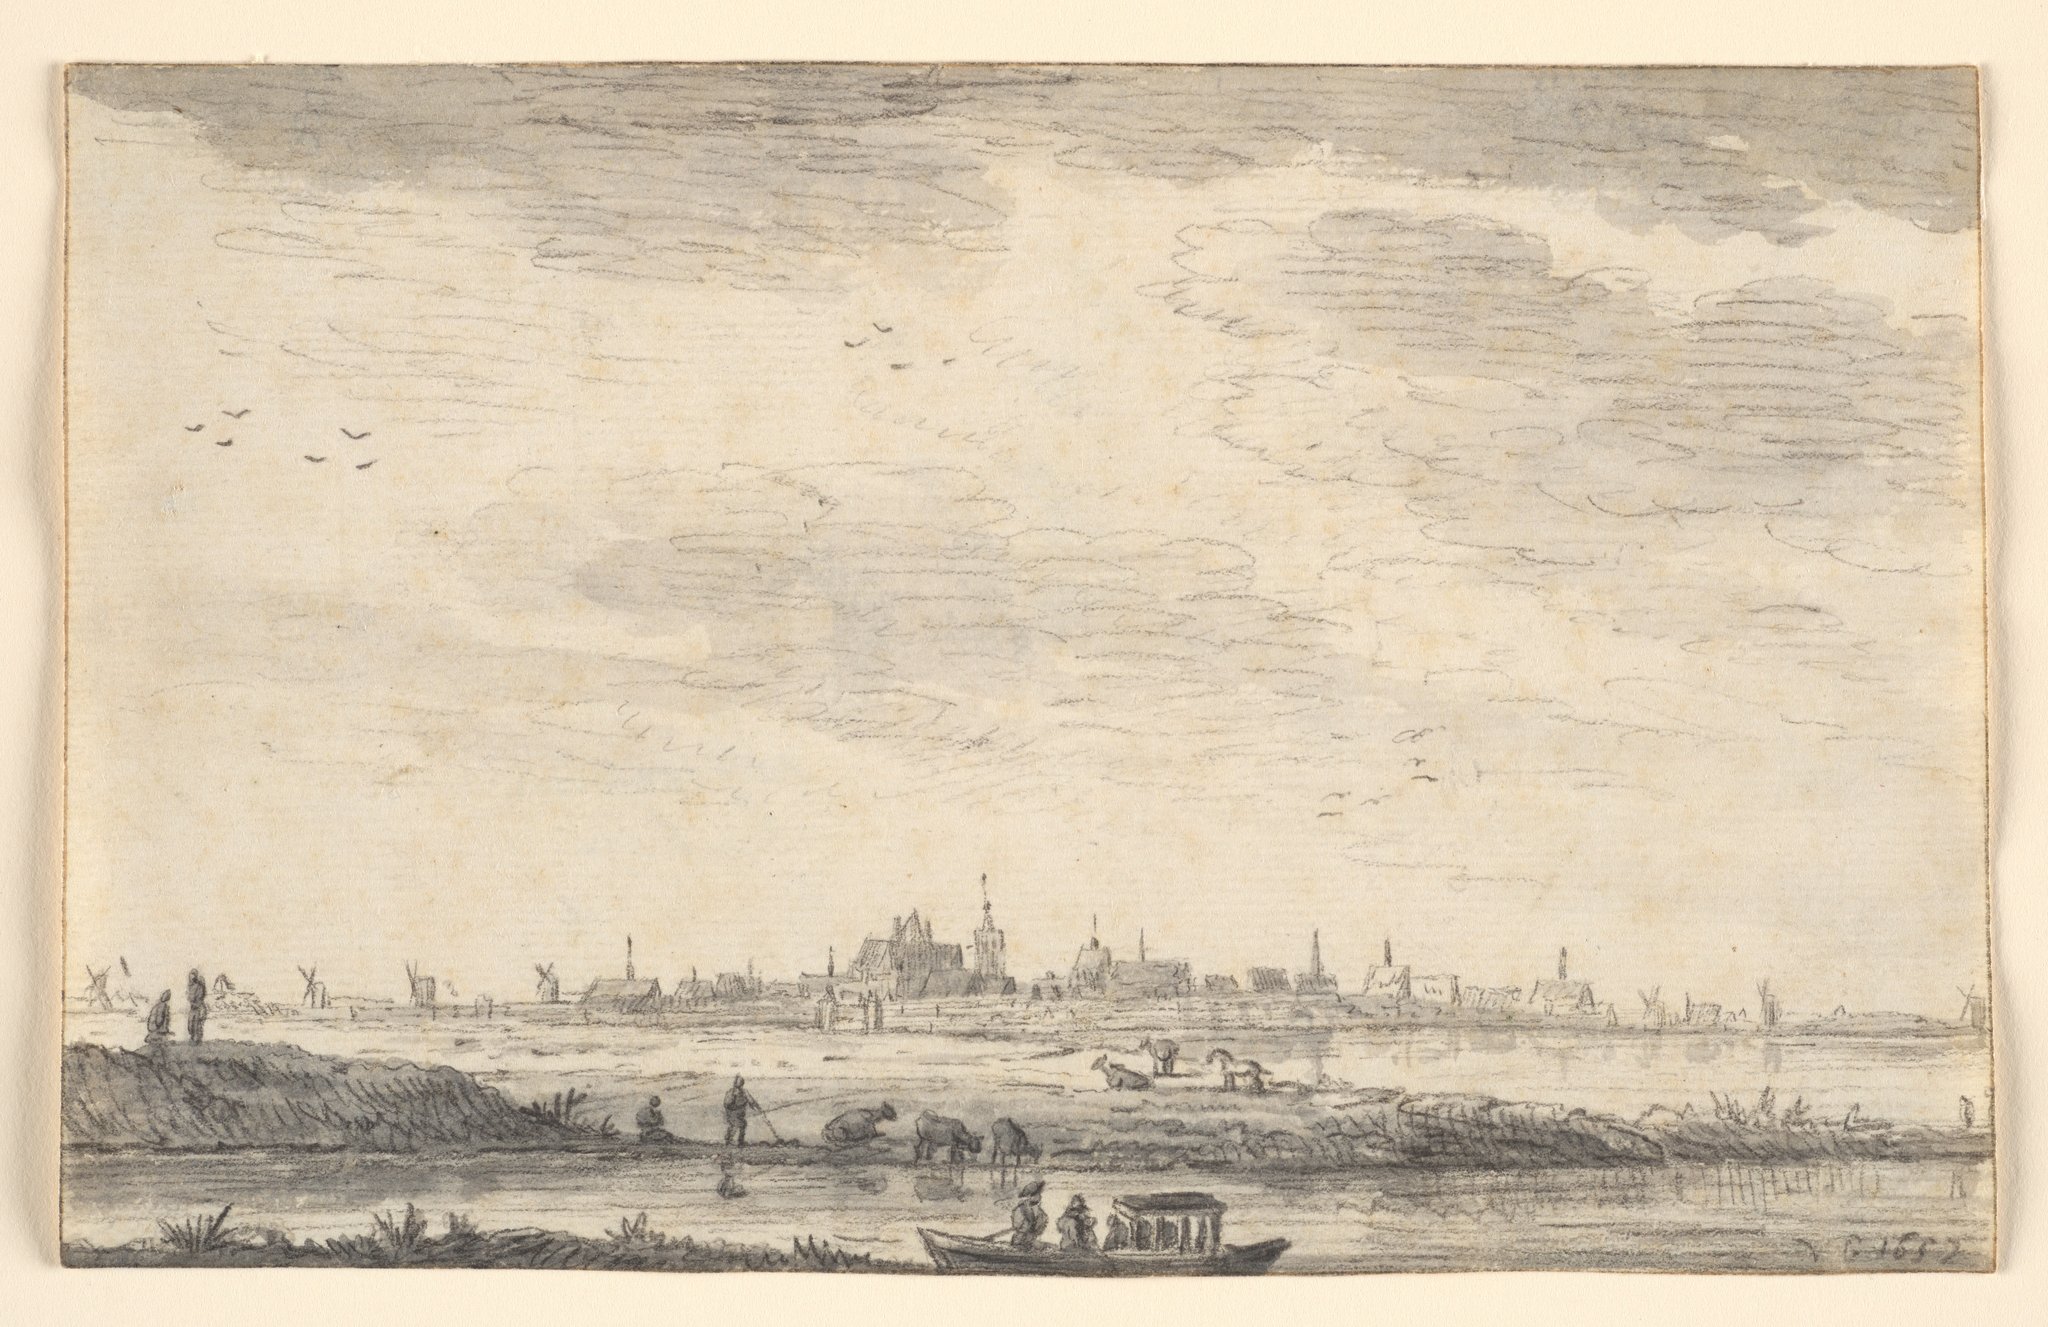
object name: drawing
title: Distant Town Seen across Water and Fields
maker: jan van goyen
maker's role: artist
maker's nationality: dutch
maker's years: 1596-1656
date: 1652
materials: chalk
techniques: wash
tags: towns,landscapes